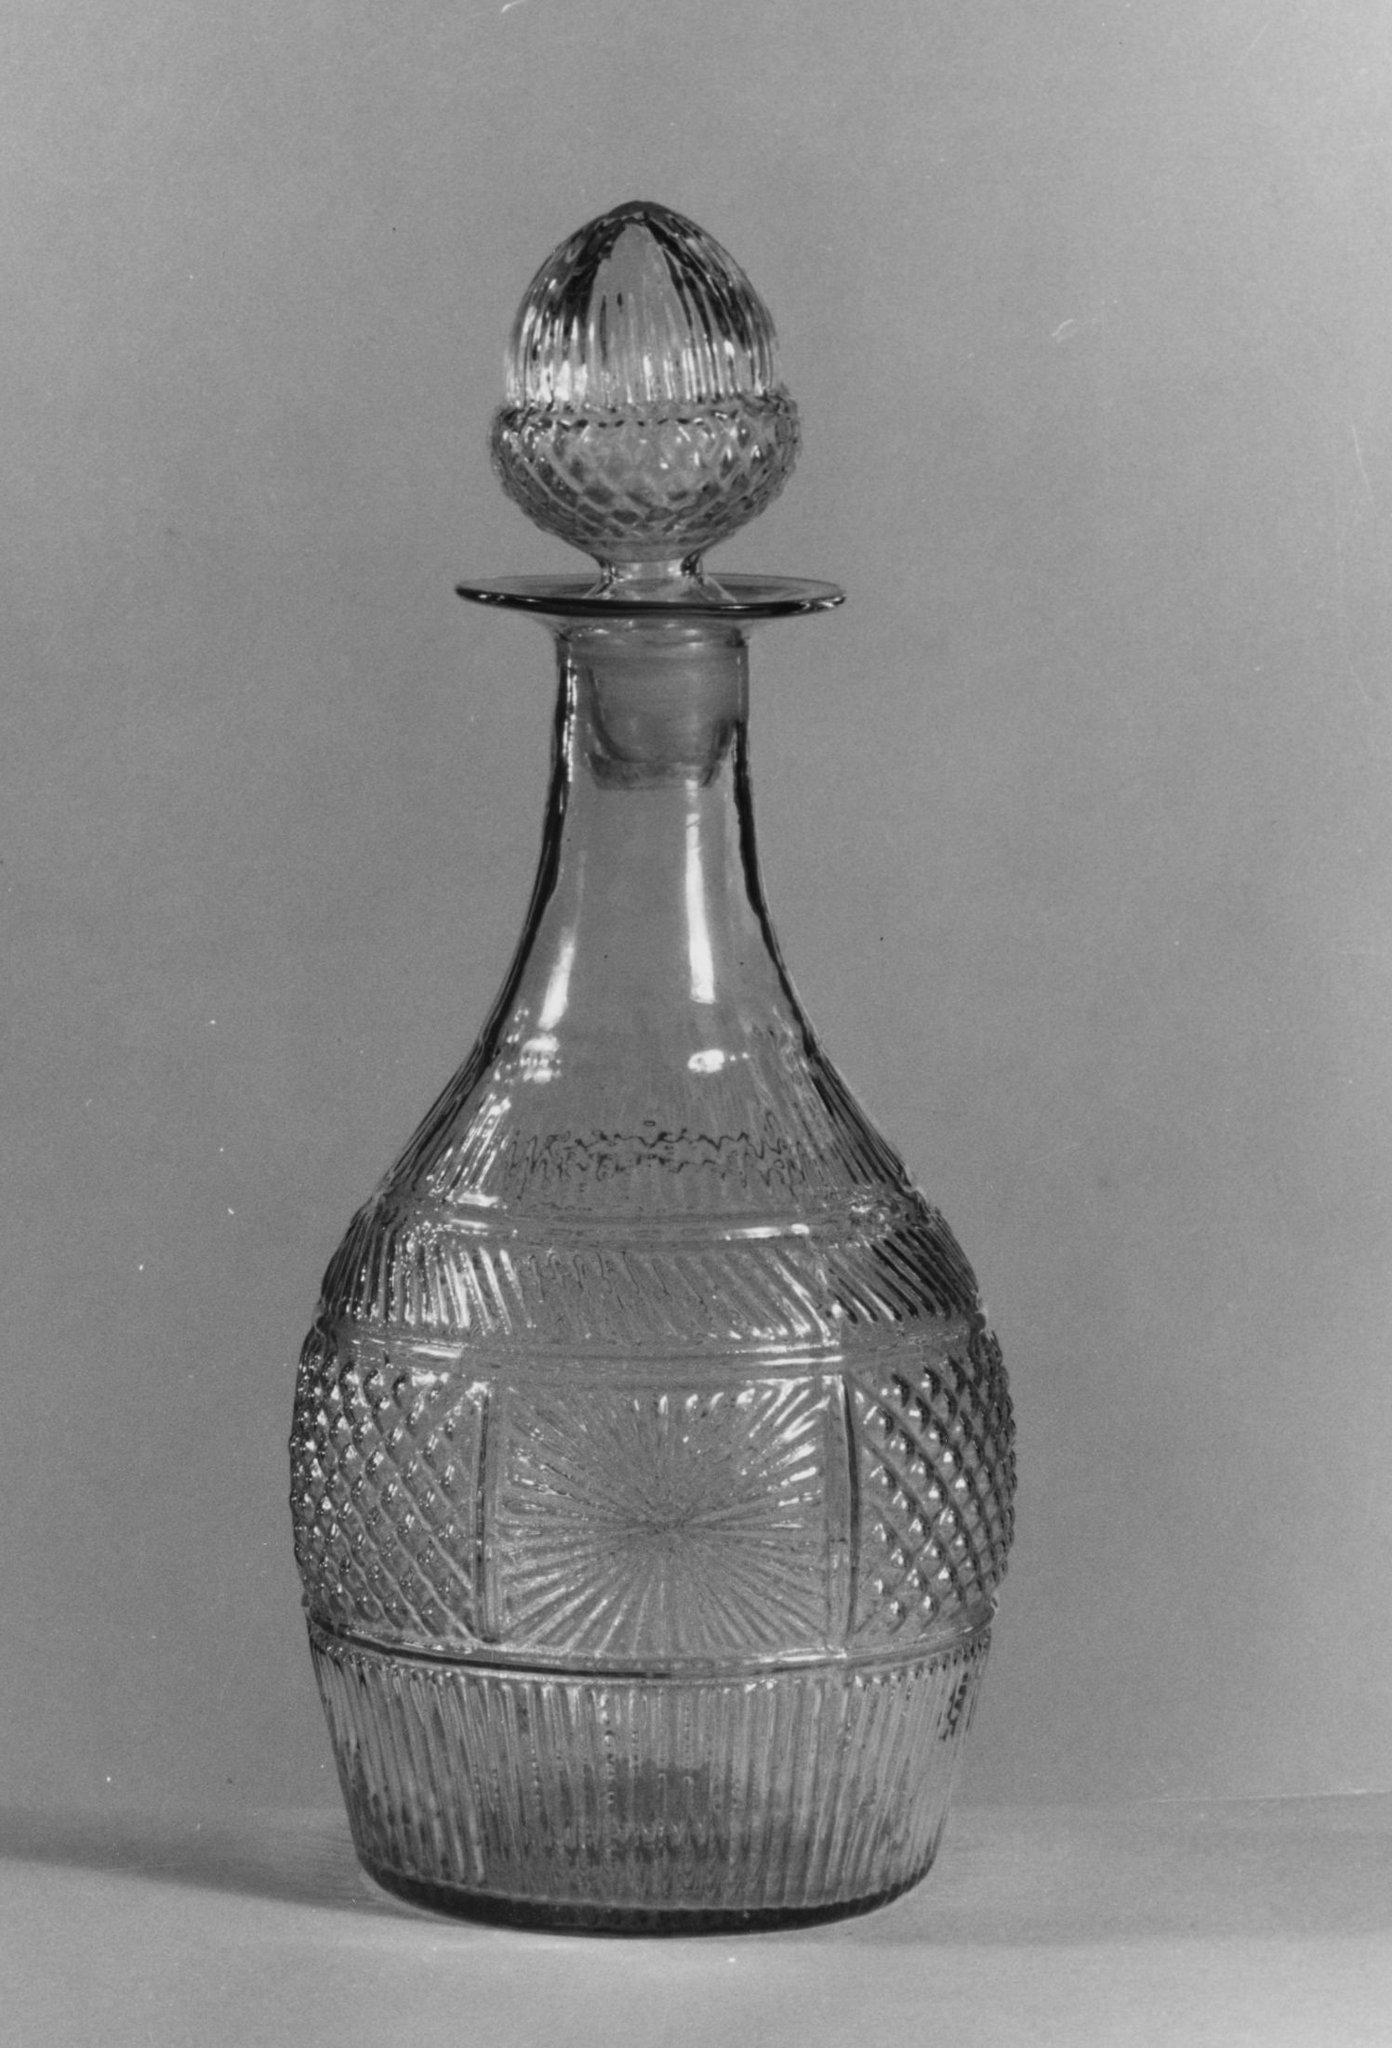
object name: decanter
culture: american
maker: boston & sandwich glass company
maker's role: maker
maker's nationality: american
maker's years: 1825-1888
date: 1820-1840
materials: glass, lead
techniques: glassblowing, molding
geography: united states